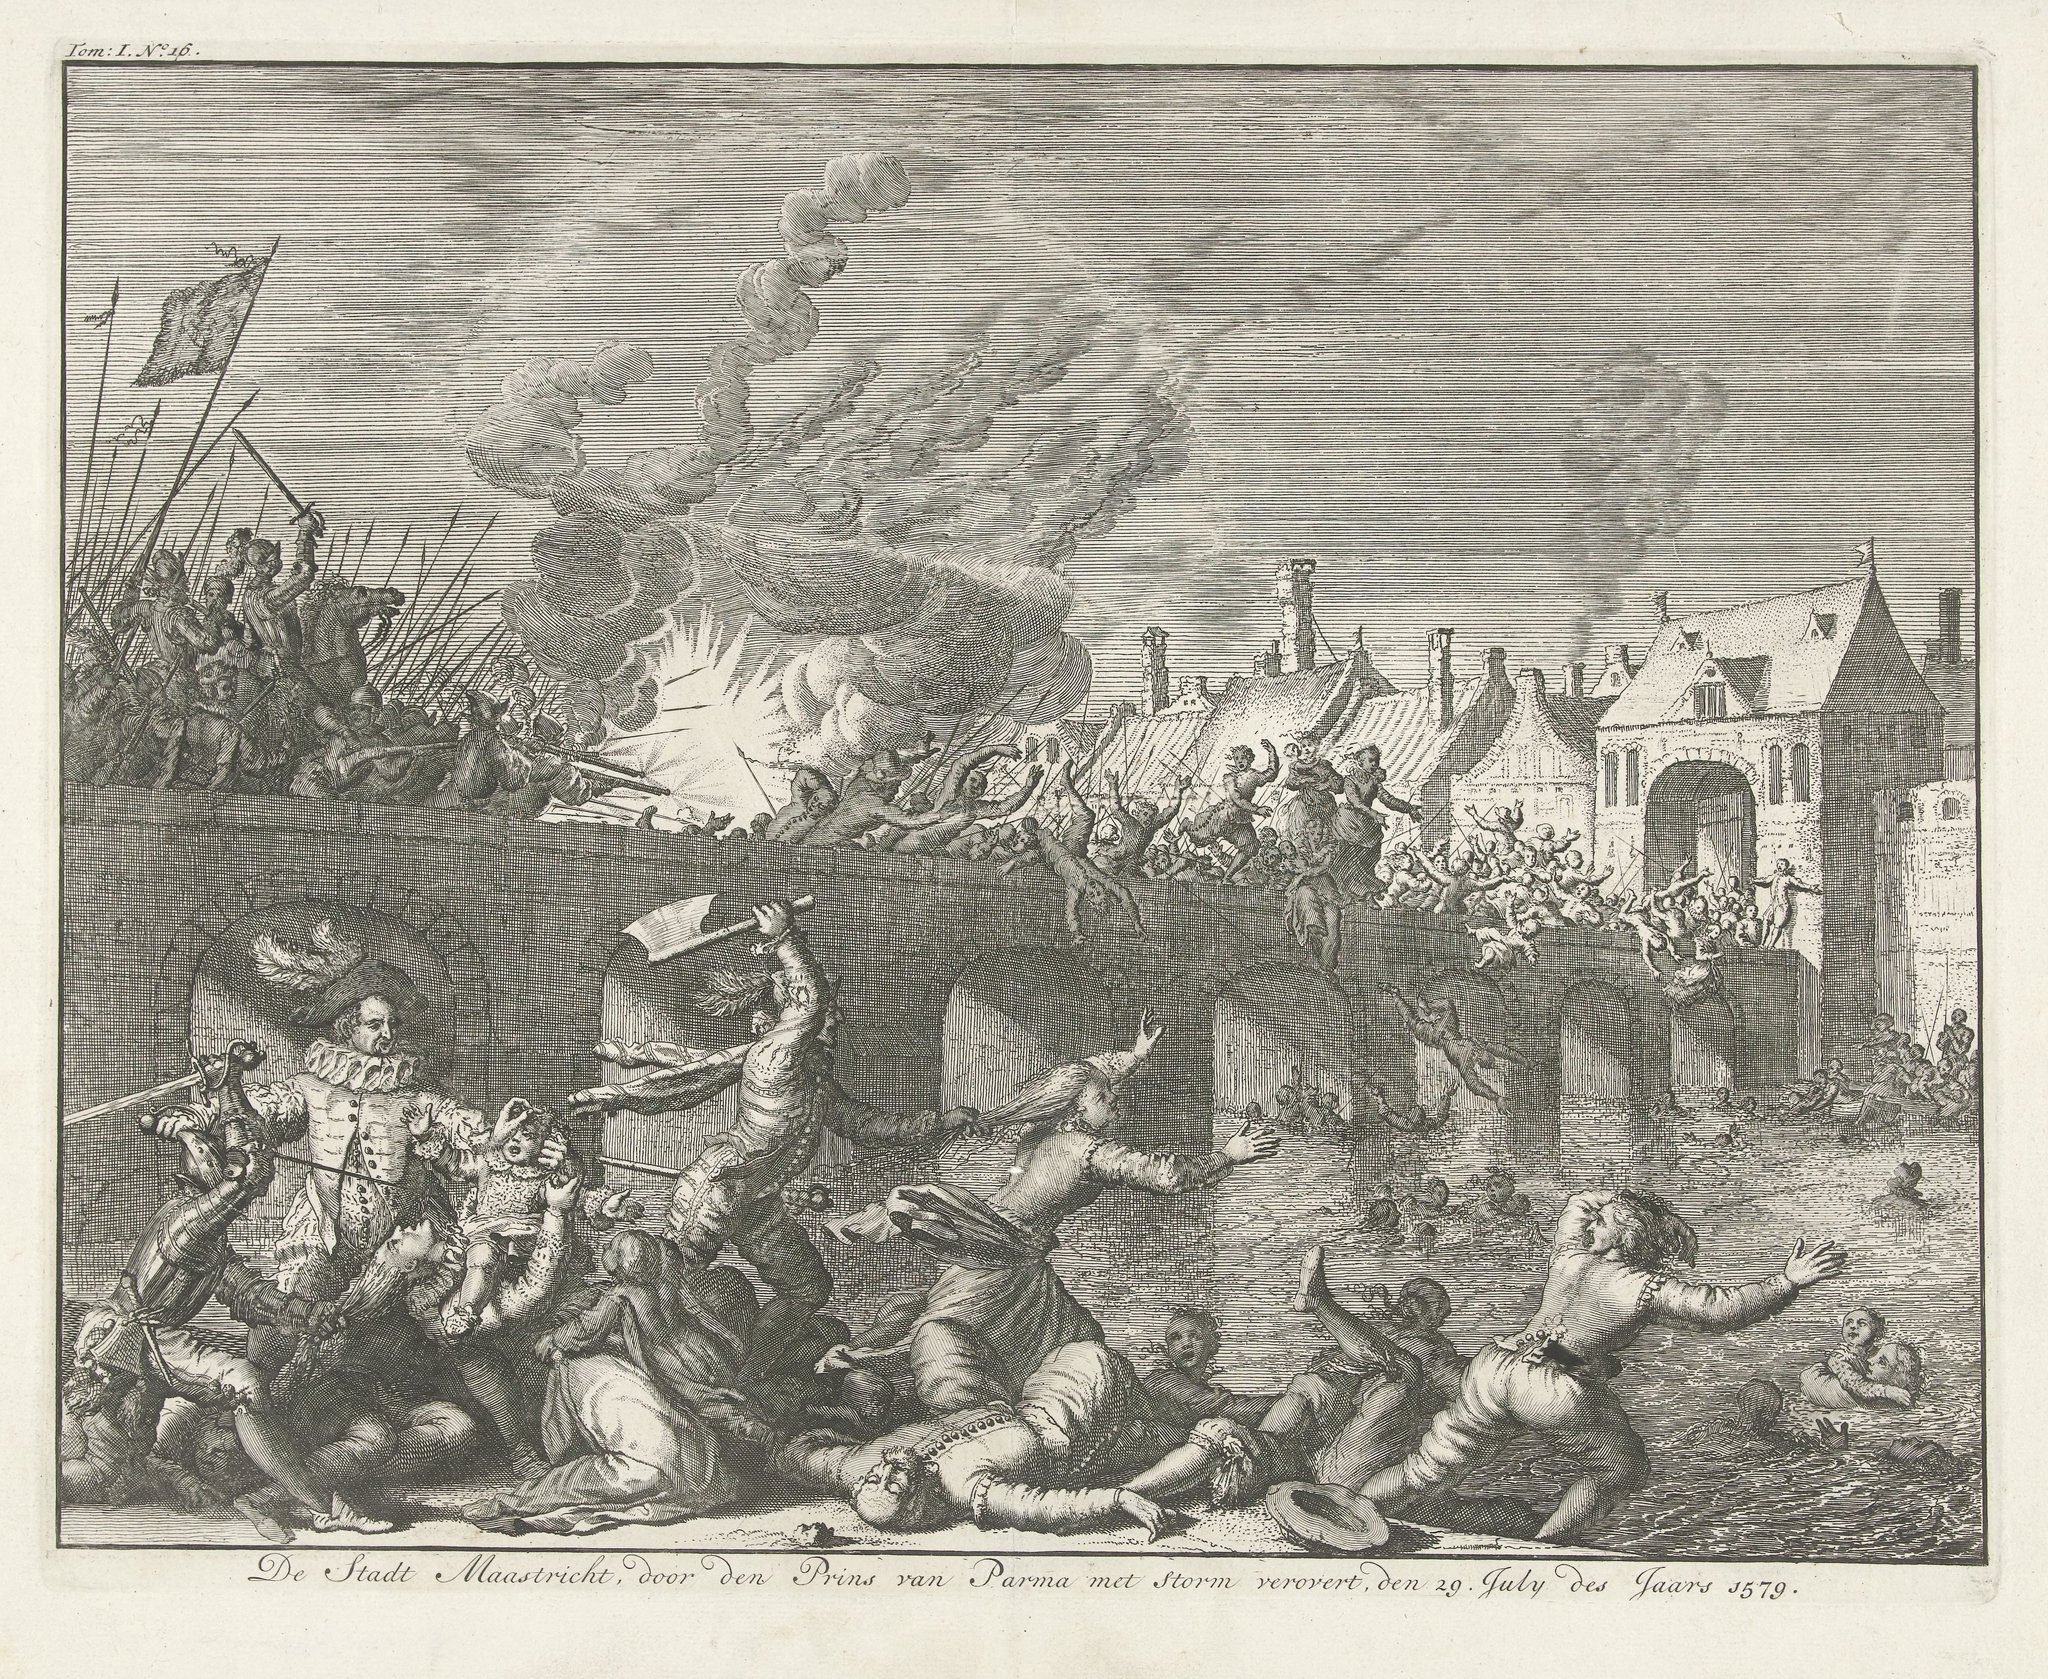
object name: history print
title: De Stadt Maastricht, door den Prins van Parma met storm verovert, den 29 July des Jaars 1579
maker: jan luyken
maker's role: draughtsman, print maker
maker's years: 1649-1712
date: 1678-1680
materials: paper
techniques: engraving, etching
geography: northern netherlands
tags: massacre ~ war, maastricht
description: Gebruikt als illustratie in: J. le Clerc, Geschiedenissen der Vereenigde Nederlanden, sedert den aanvang van die Republyk tot op den Vrede van Utrecht in 't jaar 1713 en het Tractaat van Barriere in 't jaar 1715 gesloten, Z. Chatelain, Amsterdam 1730, 3 delen, dl. I.